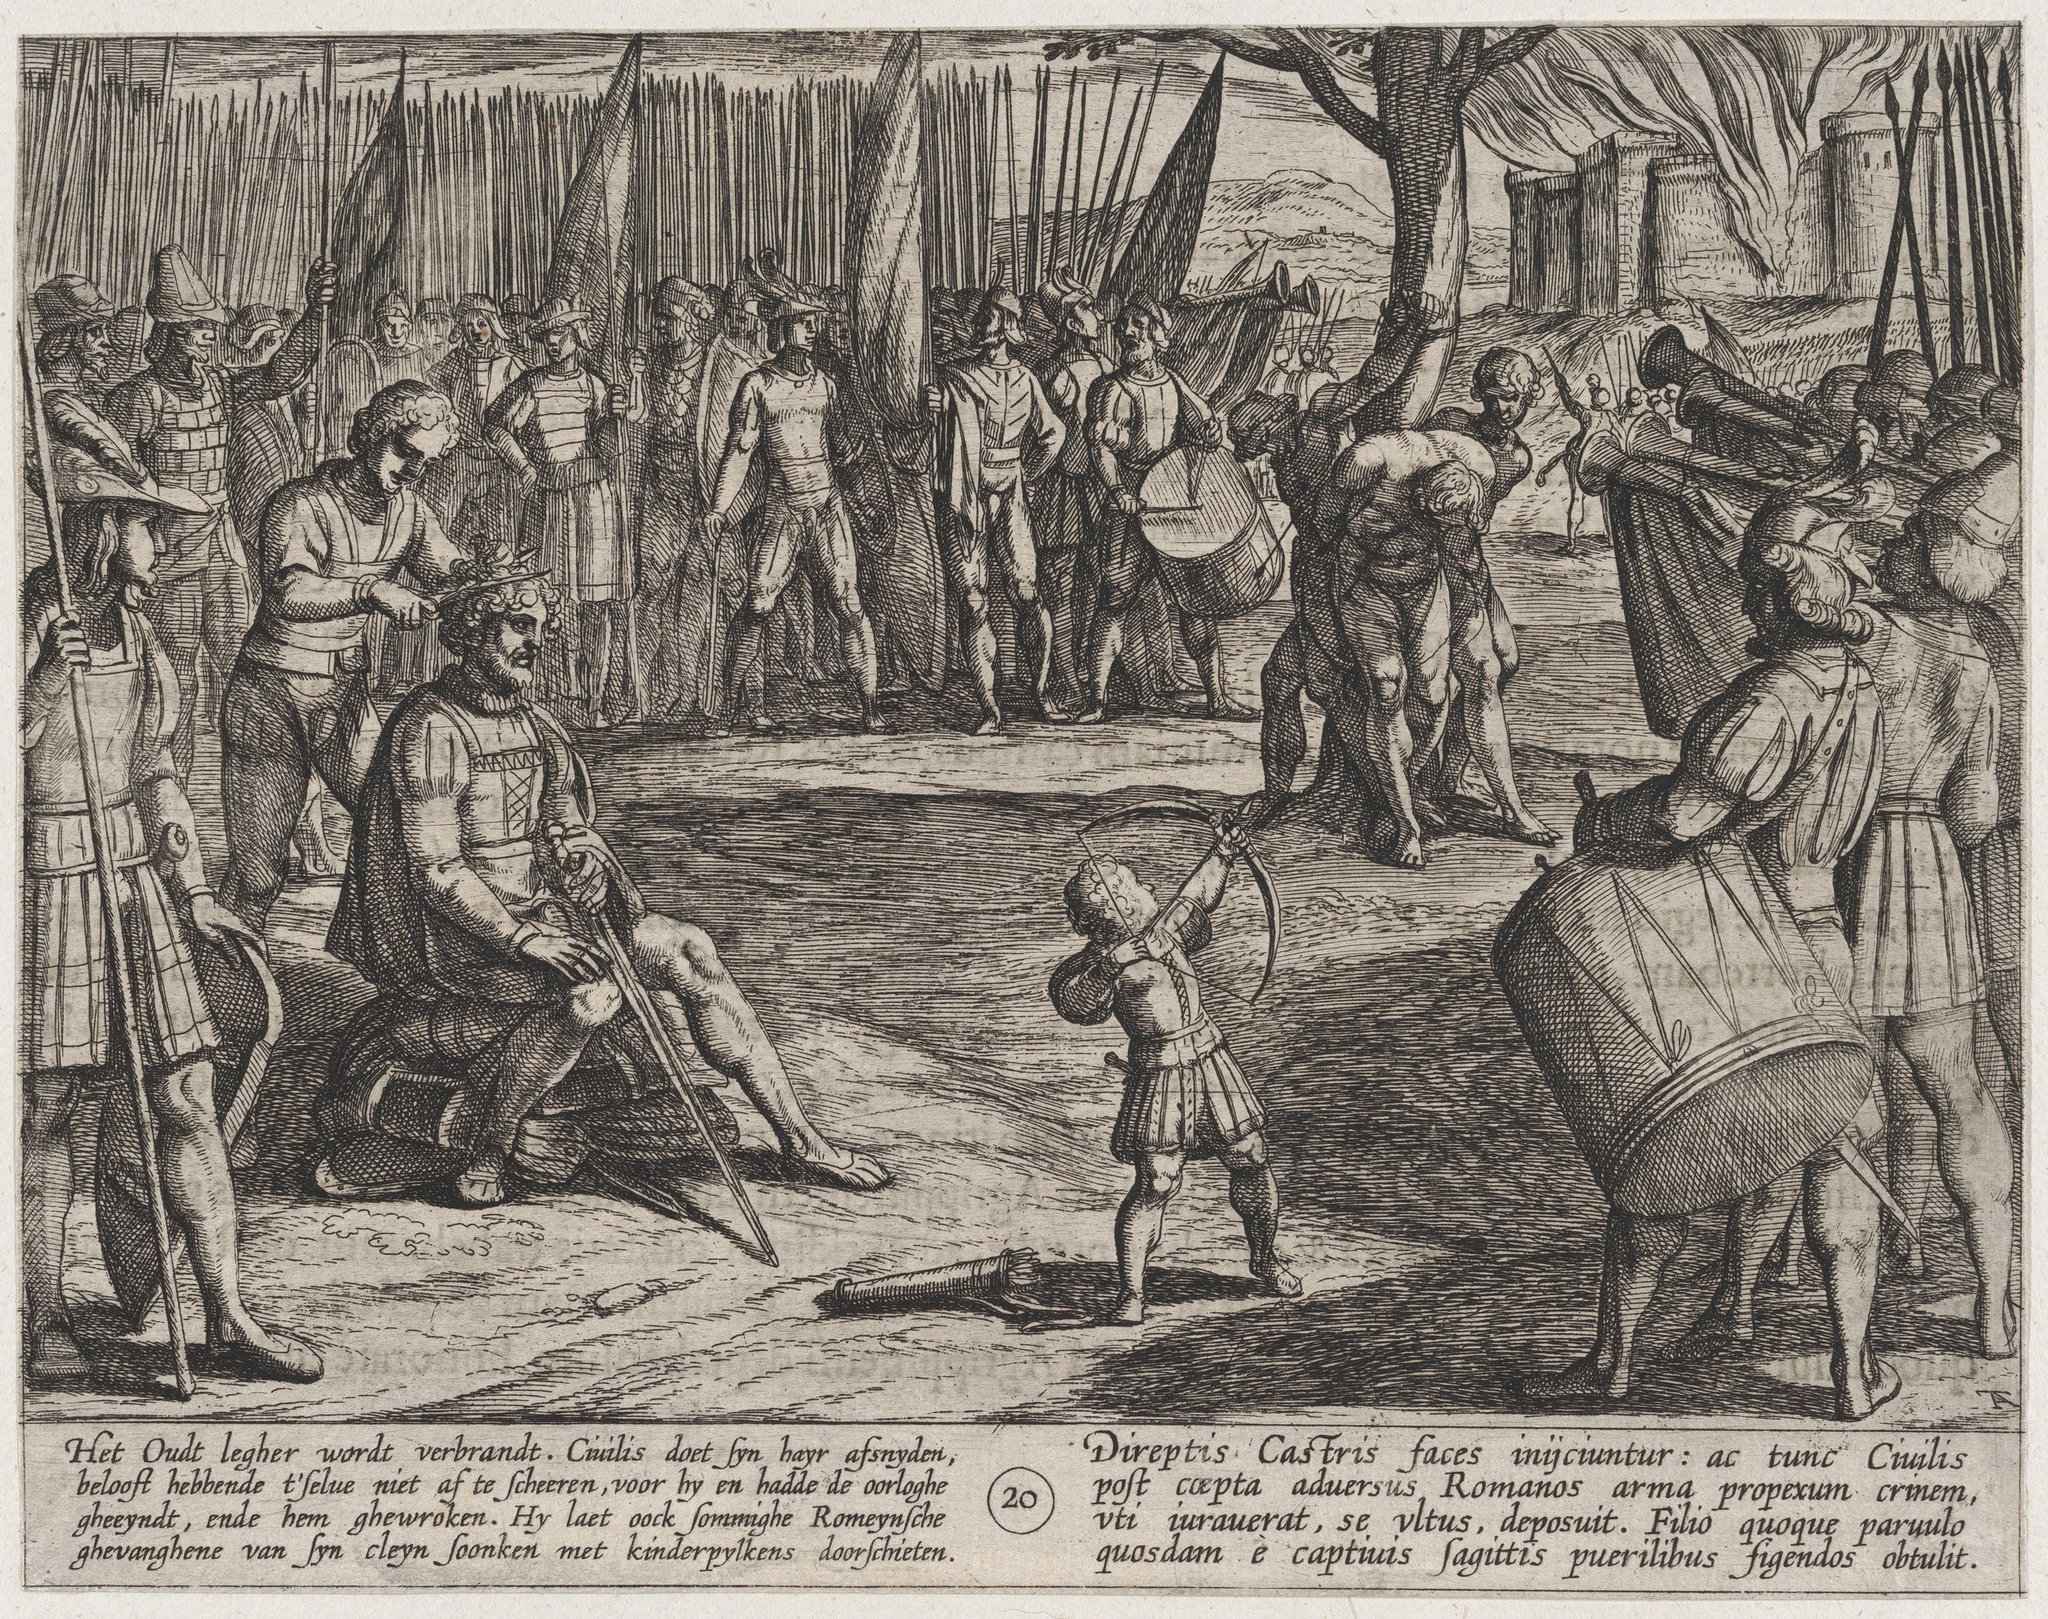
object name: print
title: Plate 20: Civilis Having his Hair Cut, from The War of the Romans Against the Batavians (Romanorvm et Batavorvm societas)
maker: antonio tempesta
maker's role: artist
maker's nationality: italian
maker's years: 1555-1630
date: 1611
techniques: etching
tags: soldiers,men,working